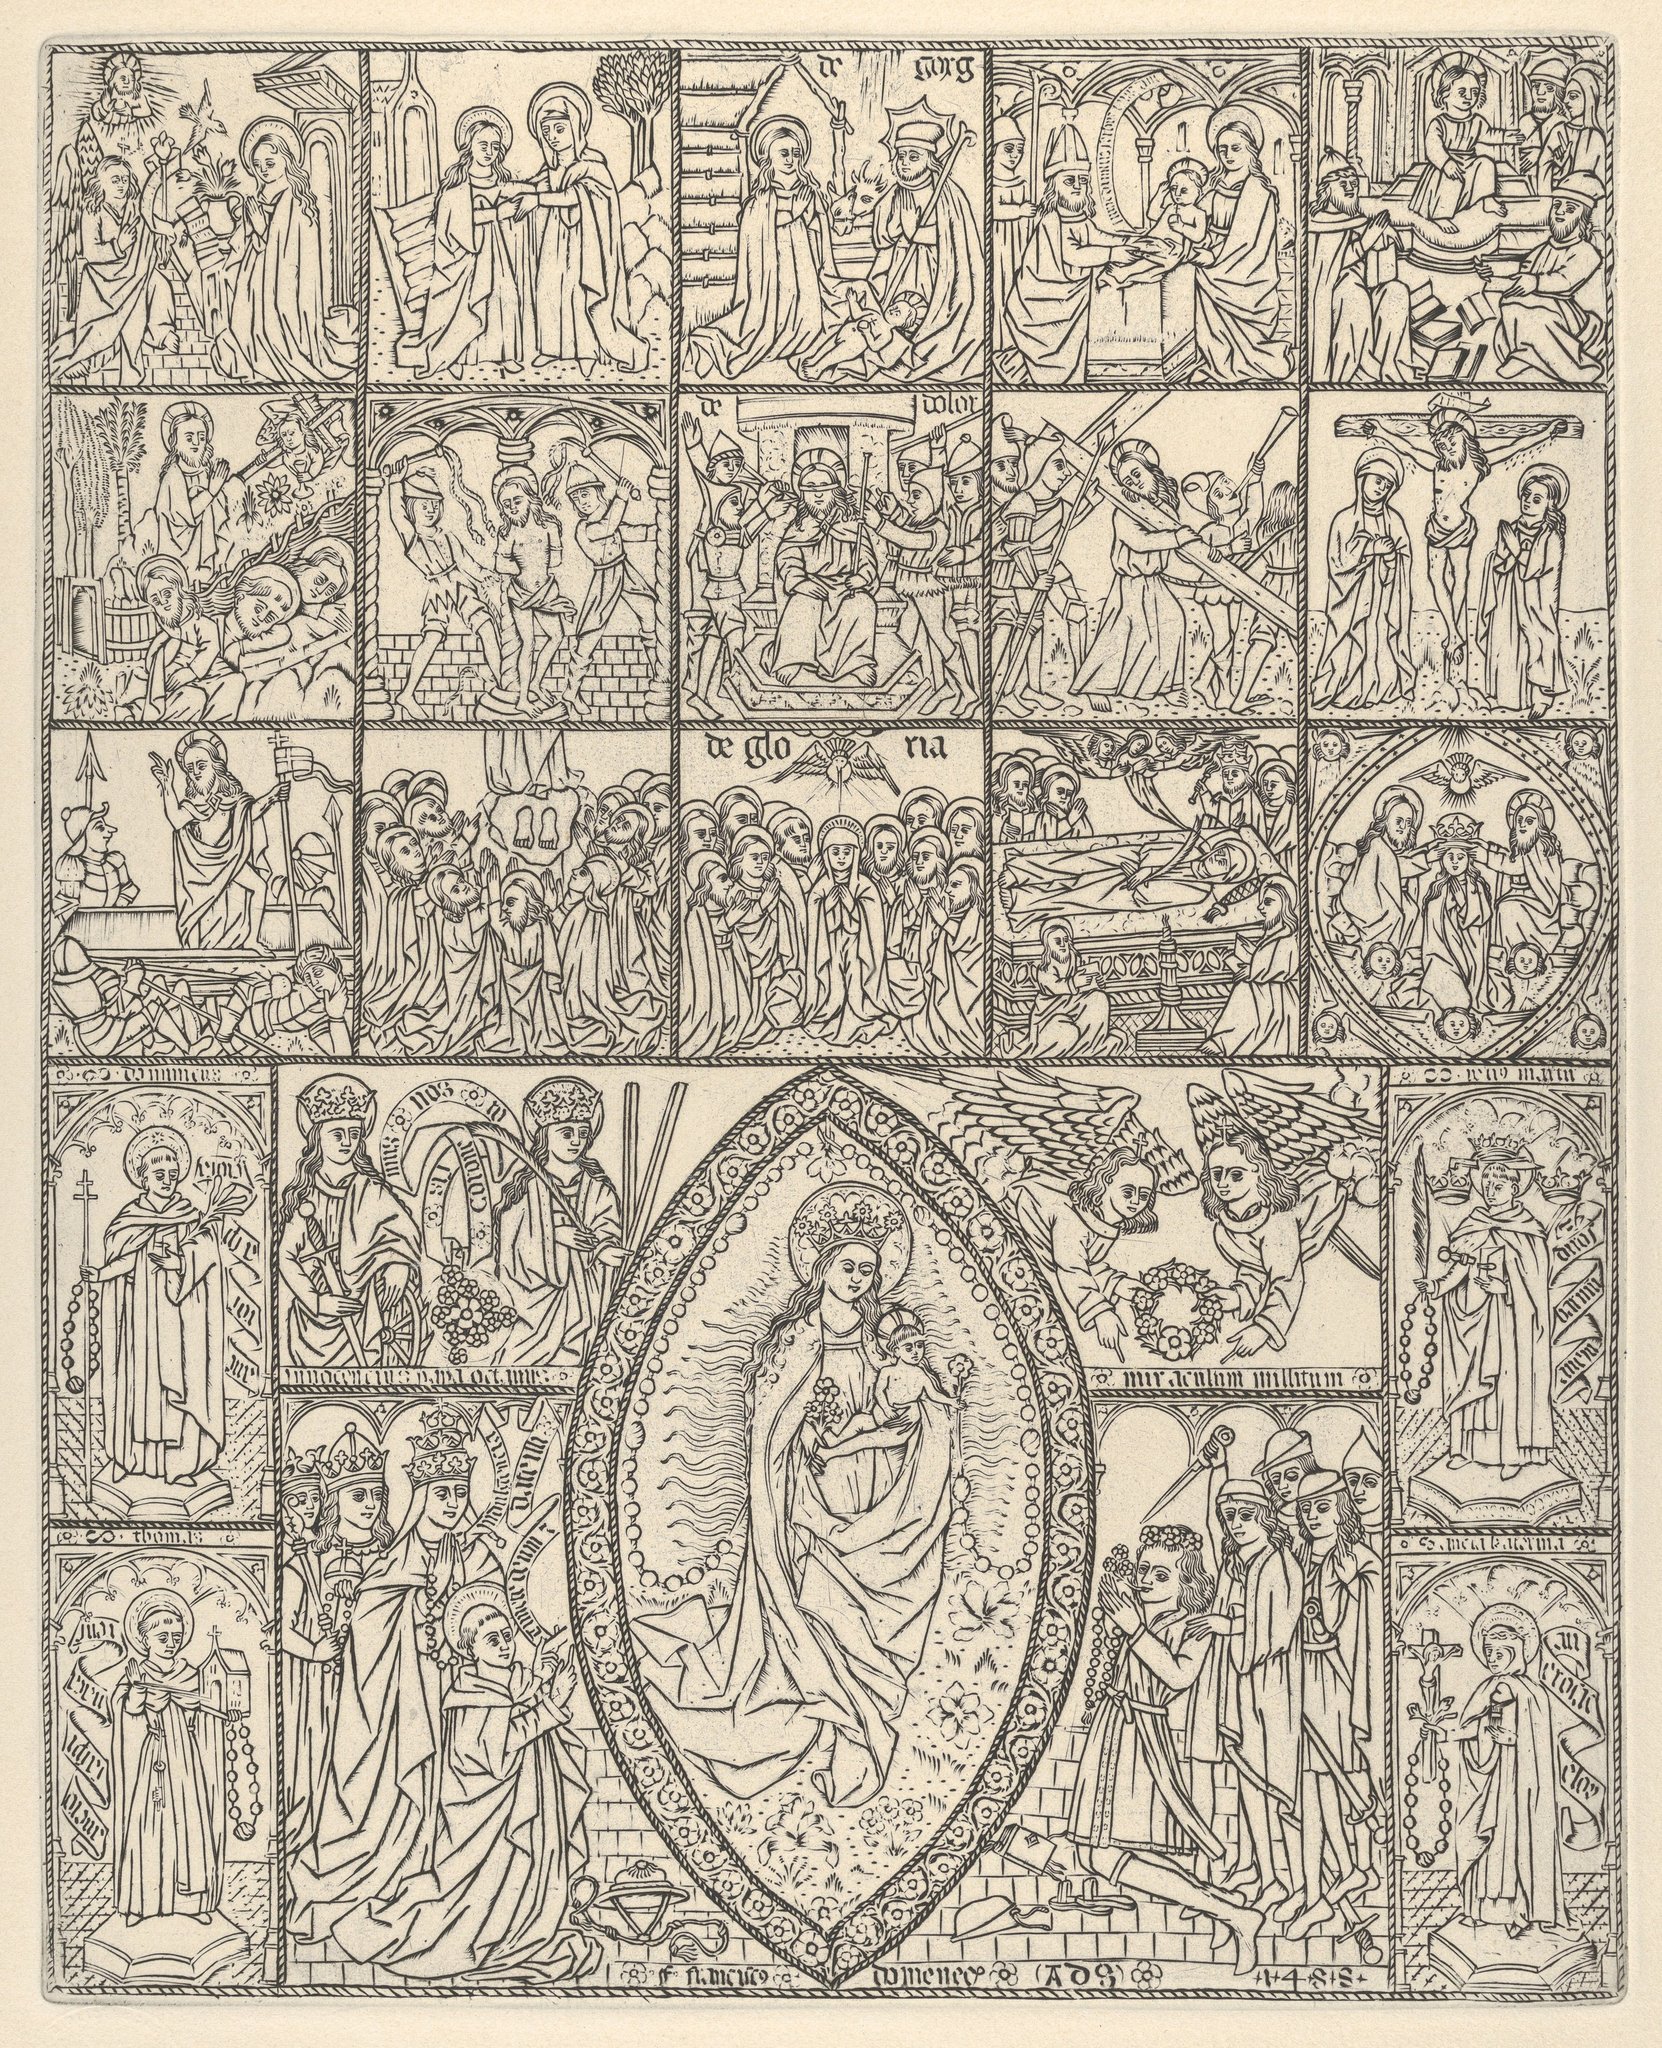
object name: print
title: The Fifteen Mysteries and the Virgin of the Rosary (Modern Impression)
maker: francisco doménech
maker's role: artist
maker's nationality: spanish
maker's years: 1445-1494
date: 1488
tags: angels,apostles,madonna and child